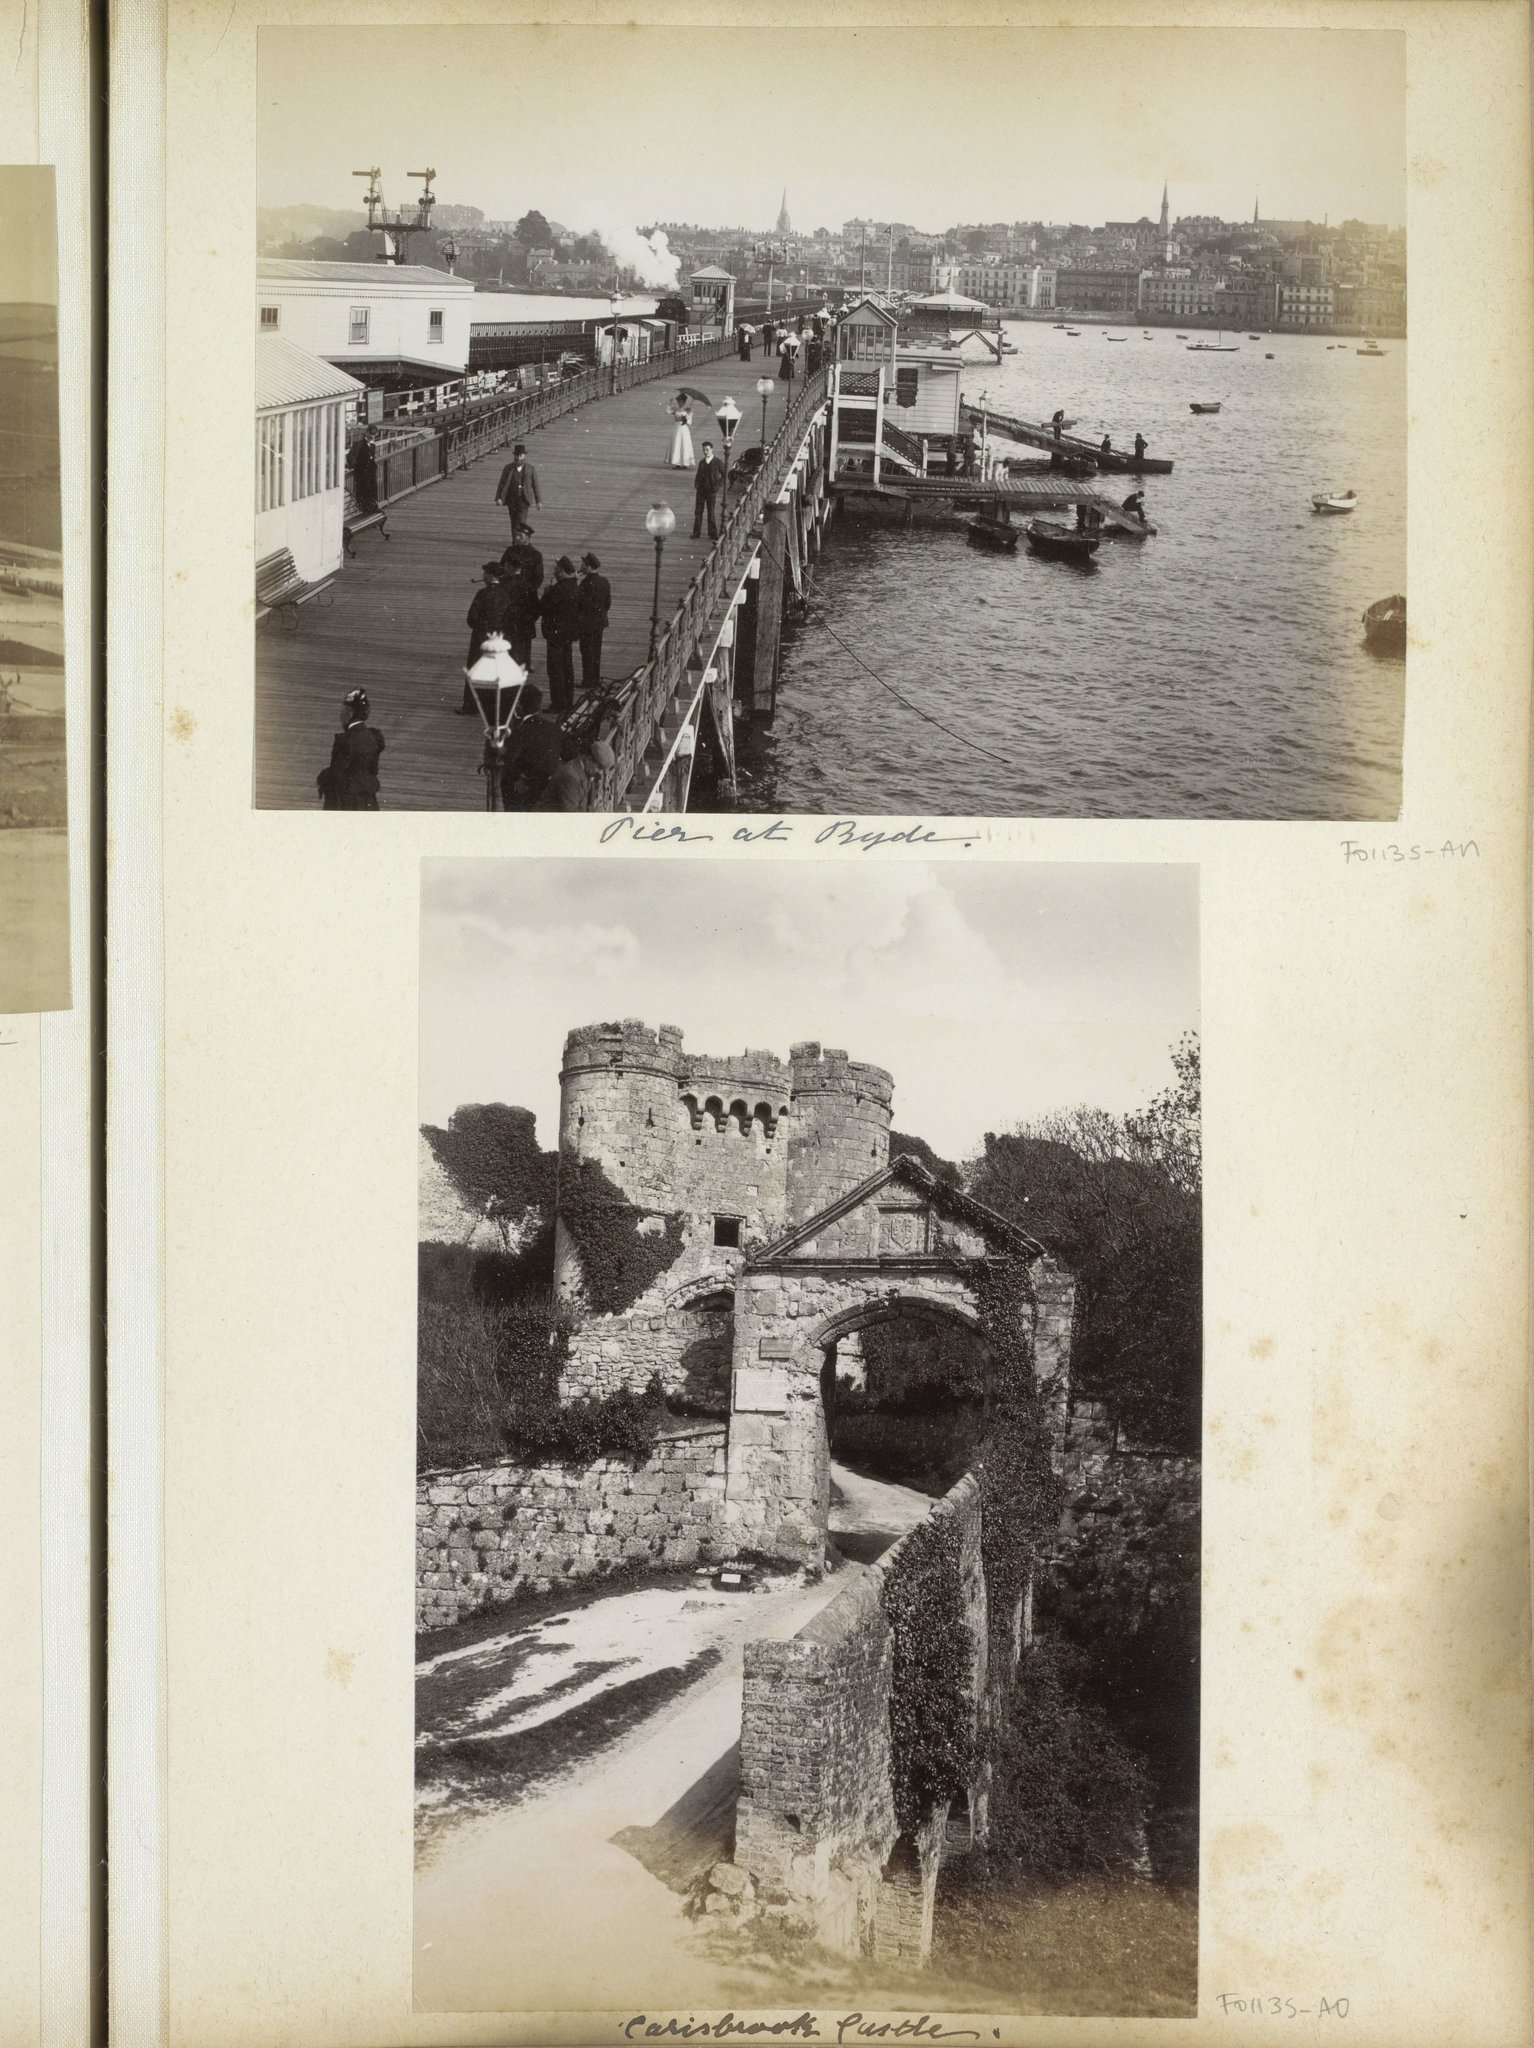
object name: photograph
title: Gezicht op de toegangspoort en torens van het kasteel van Carisbrooke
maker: frederick nutt broderick jr.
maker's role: fotograaf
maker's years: 1854-1913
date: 1898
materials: paper, photographic support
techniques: albumen print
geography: carisbrooke castle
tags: castle, gate, entrance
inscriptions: check stamp: ‘Broderick's series’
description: Onderdeel van Reisalbum met foto's van bezienswaardigheden in Engeland en Frankrijk.